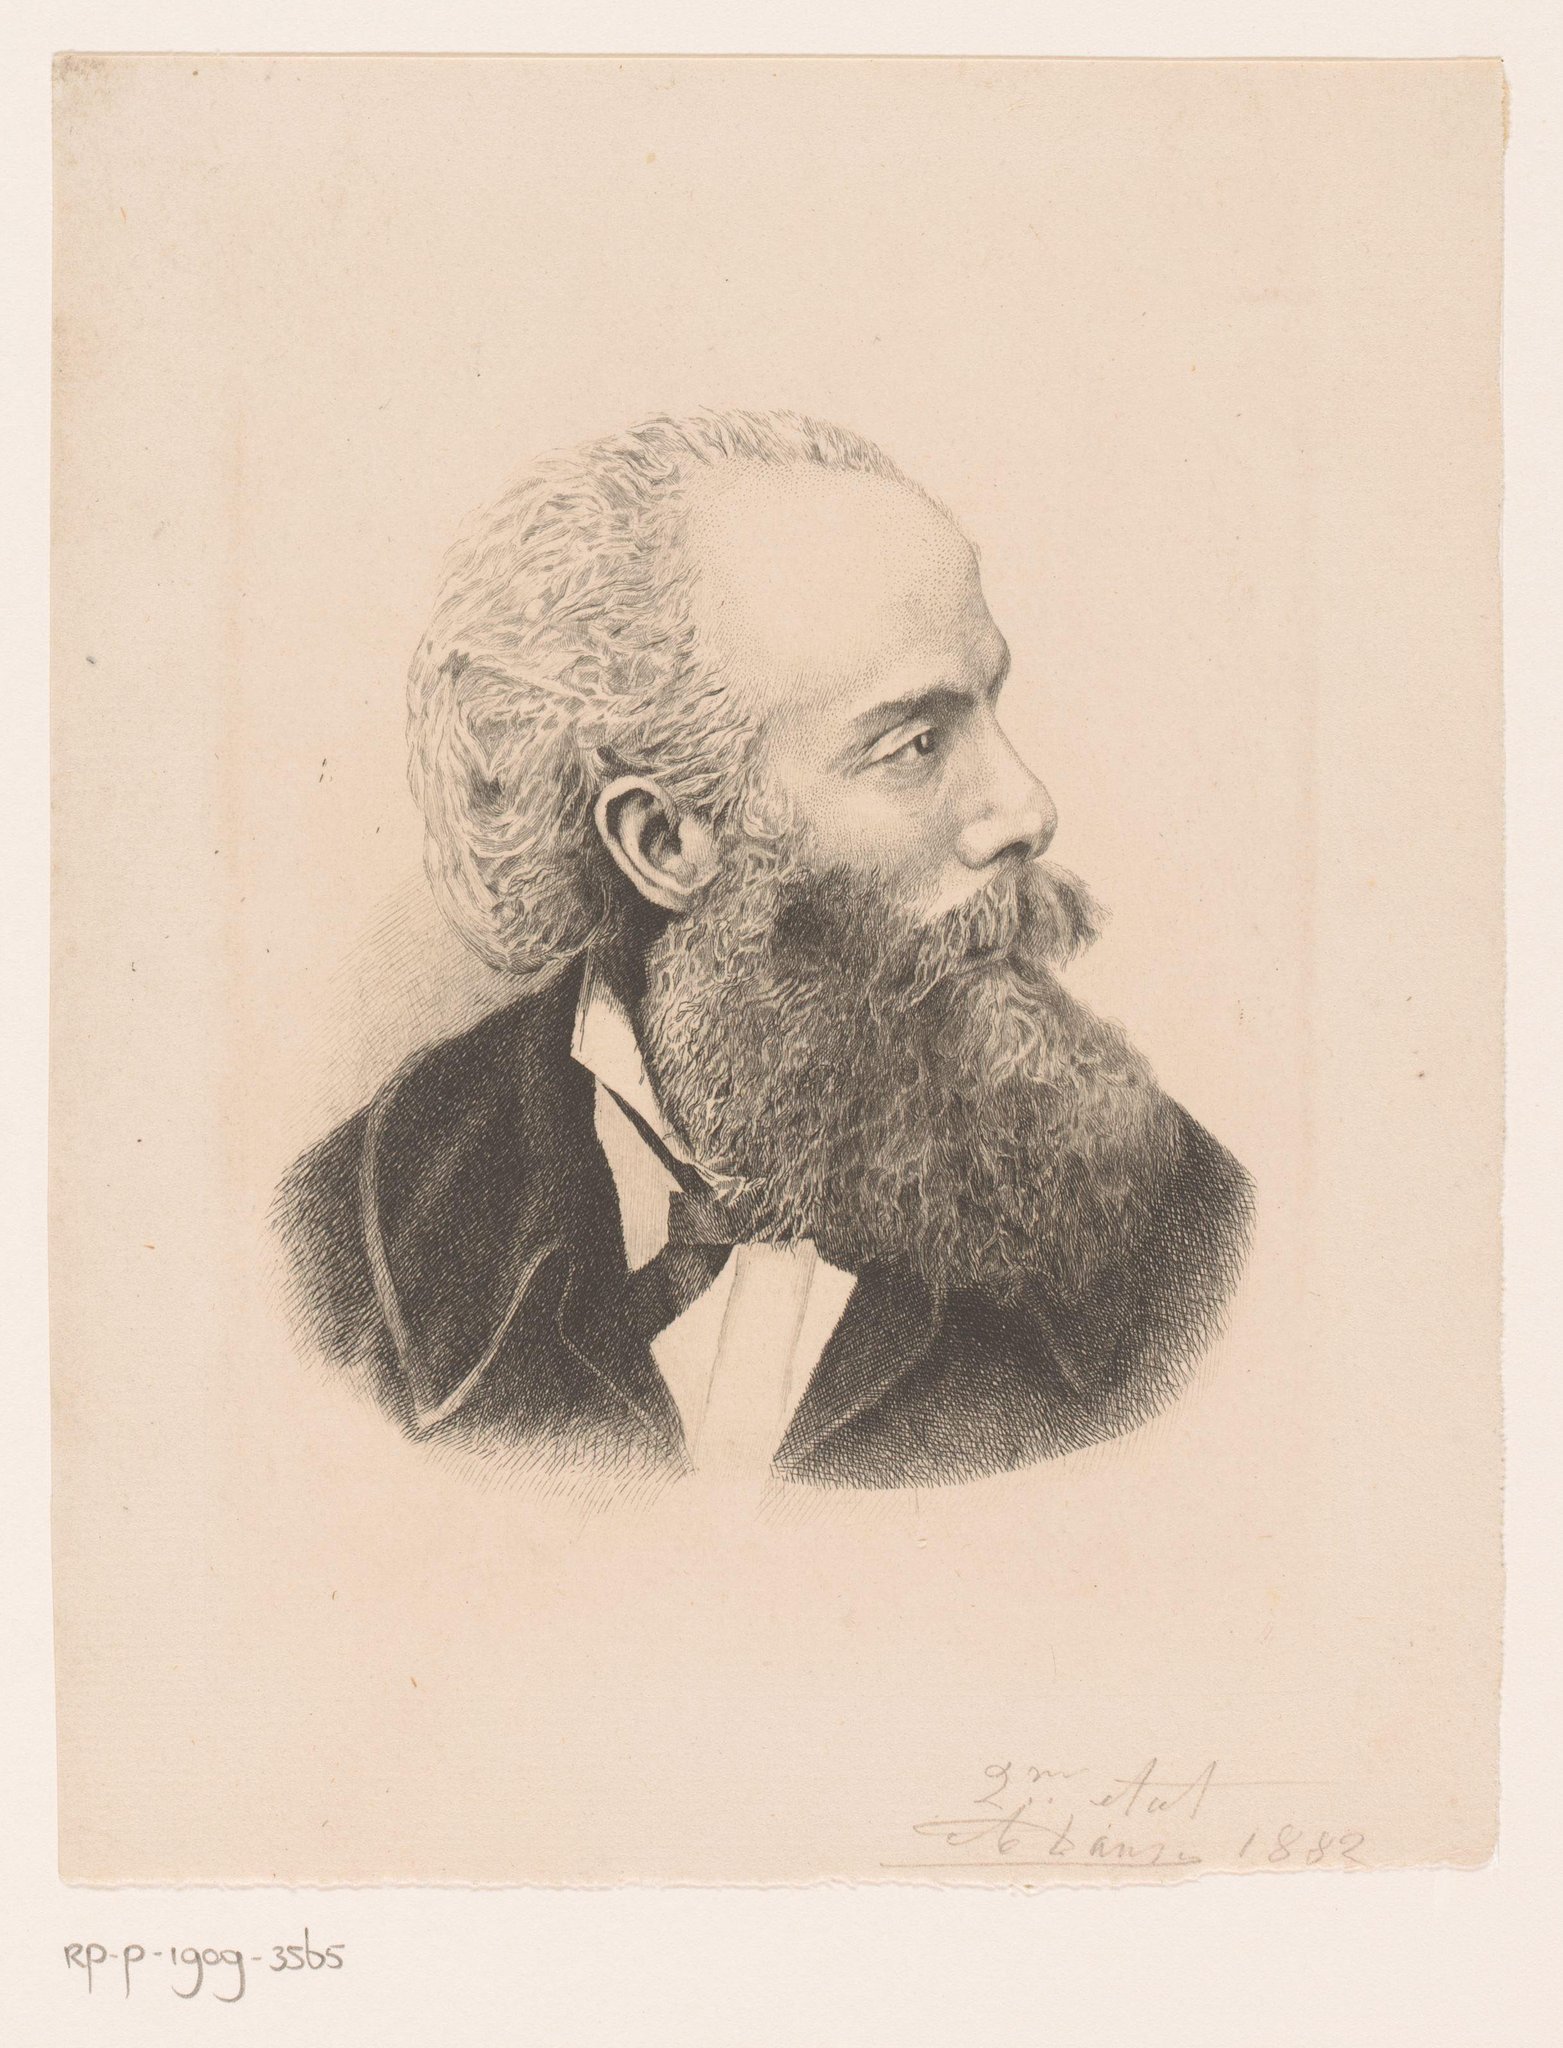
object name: print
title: Portret van Eugène Joors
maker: auguste danse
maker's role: print maker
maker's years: 1829-1929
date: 1882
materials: paper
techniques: etching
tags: painter, eugène joors, portrait, self-portrait of painter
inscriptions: annotation: ‘2me état’, collector's mark: Lugt 2228